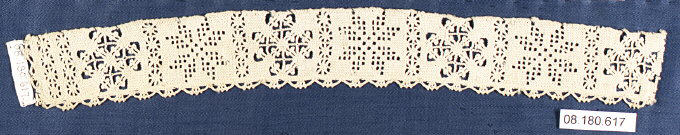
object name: fragment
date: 1801-1900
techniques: lace